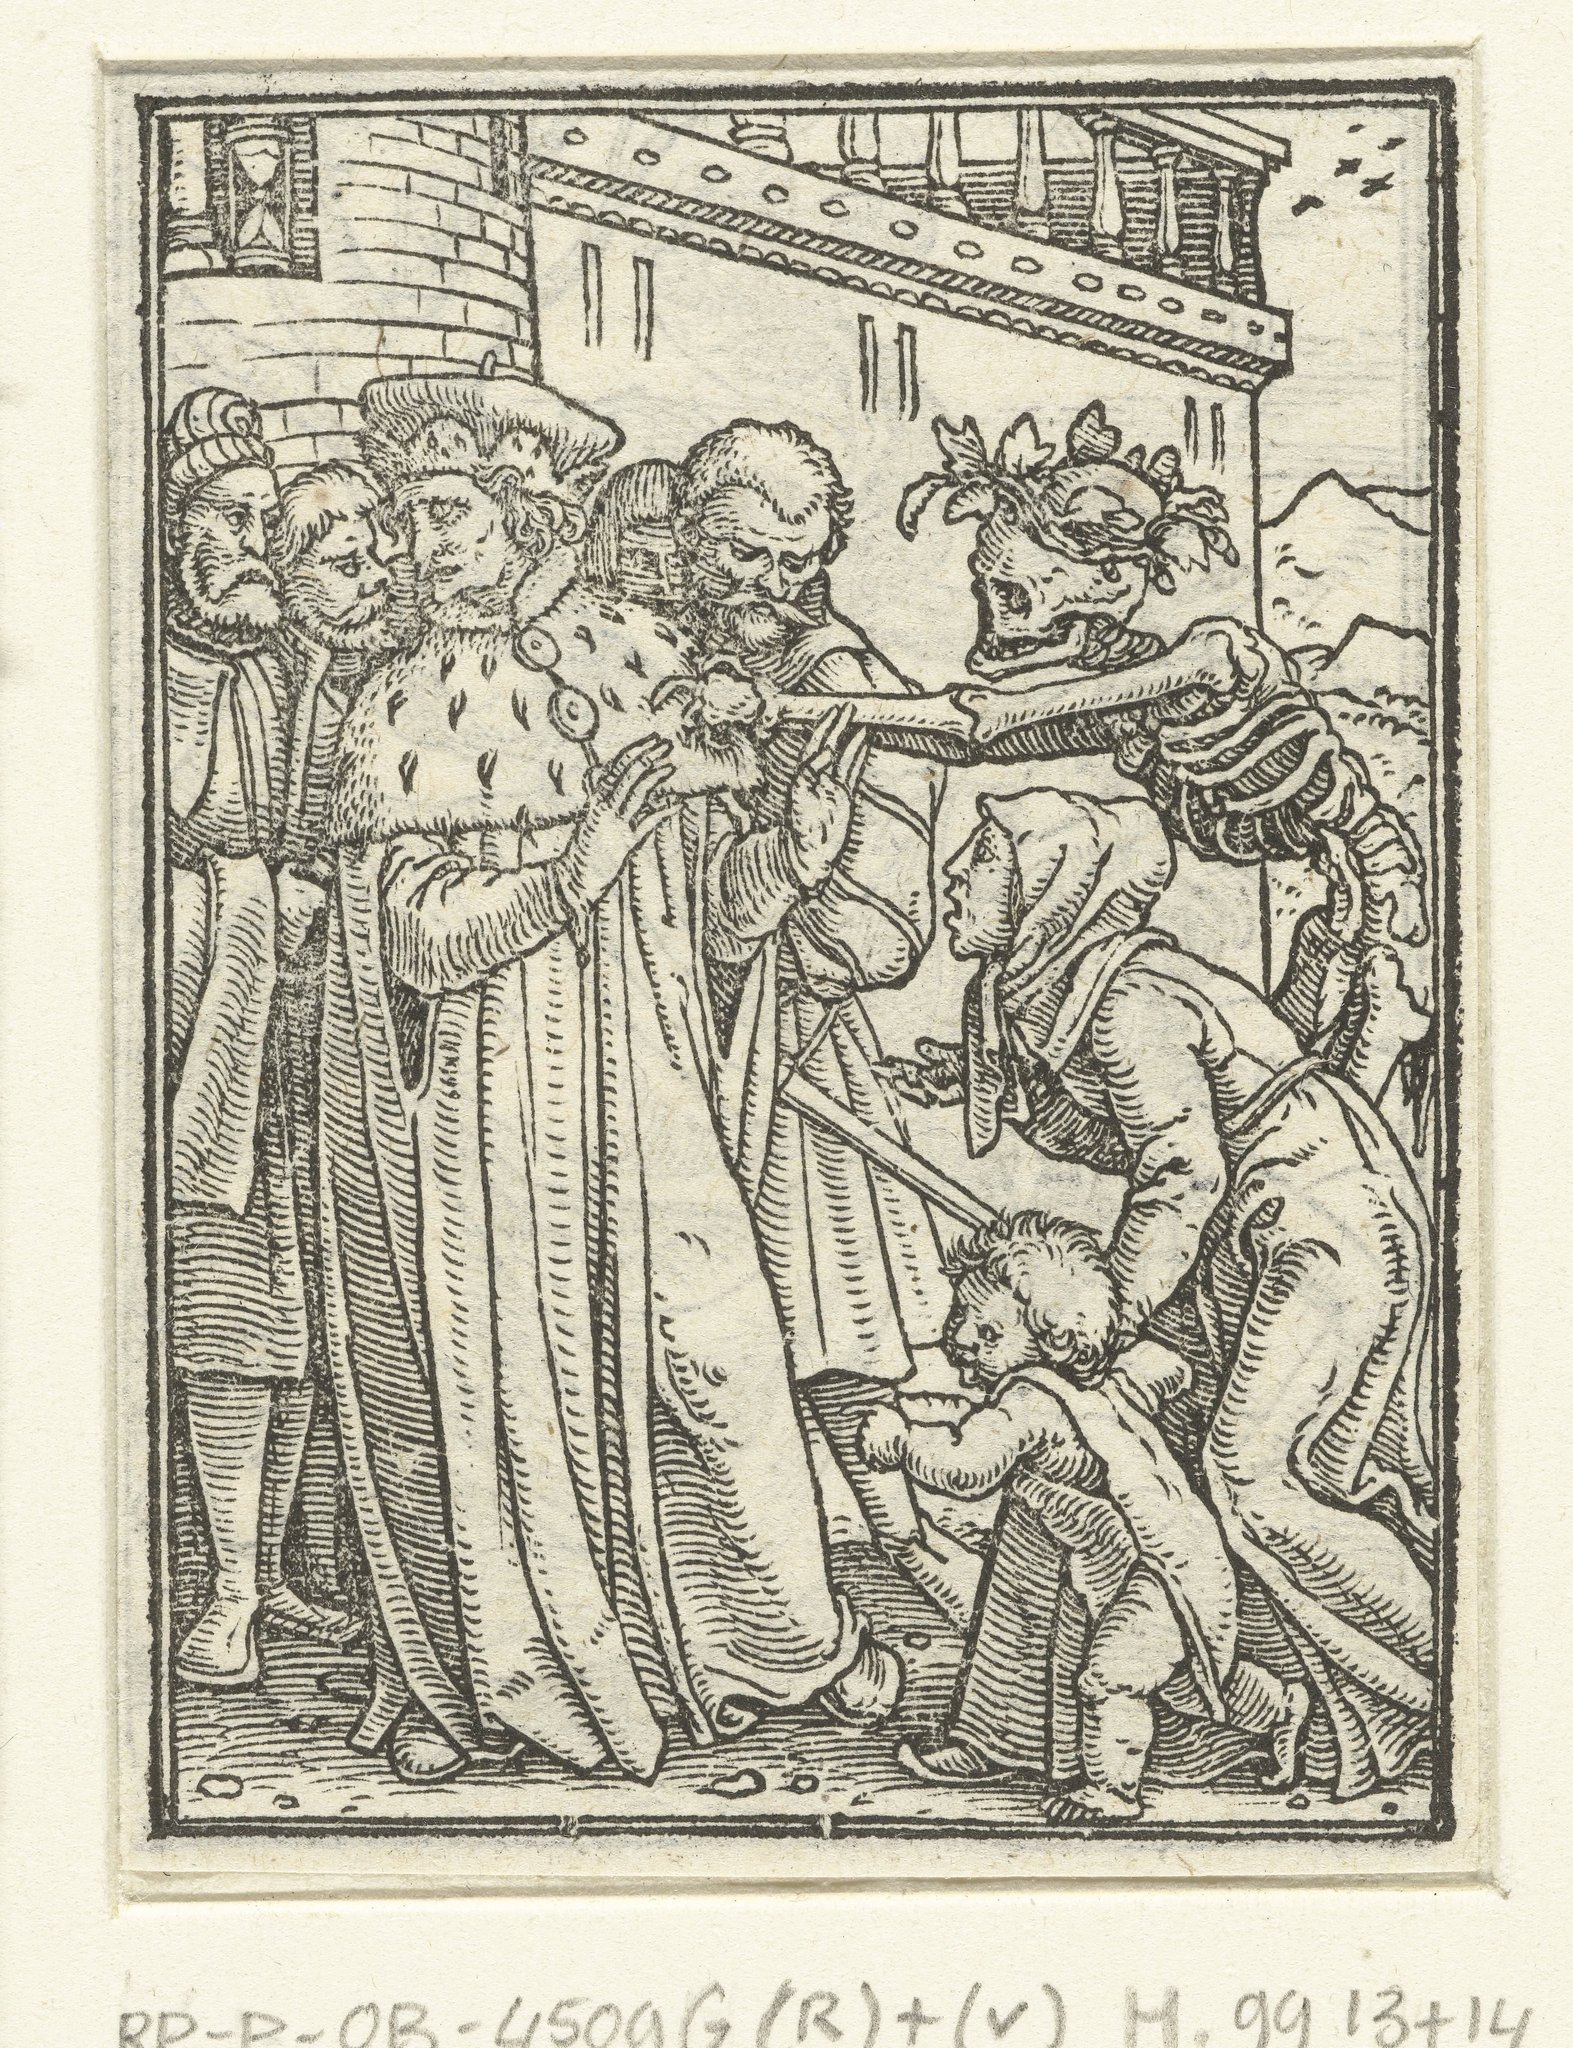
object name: book illustration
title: Dodendans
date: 1524-1526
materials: paper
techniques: woodcut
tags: dance of death; death together with one or more human beings, other sovereign (with title)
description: De houtblokken werden voor 1526 vervaardigd door Hans Lützelburg en pas in 1538 voor het eerst gebruikt als boekillustraties in: Les simulachres & historiees faces de la mort avtant elegamment pourtraictes que artificiellement imaginées... a Lyon, Soubsz l'escu de Coloigne, MDXXXVIII, (M. en G. Trechsel, voor F. Frellon in Lyon), 1538. Later verschenen nog andere uitgaven.